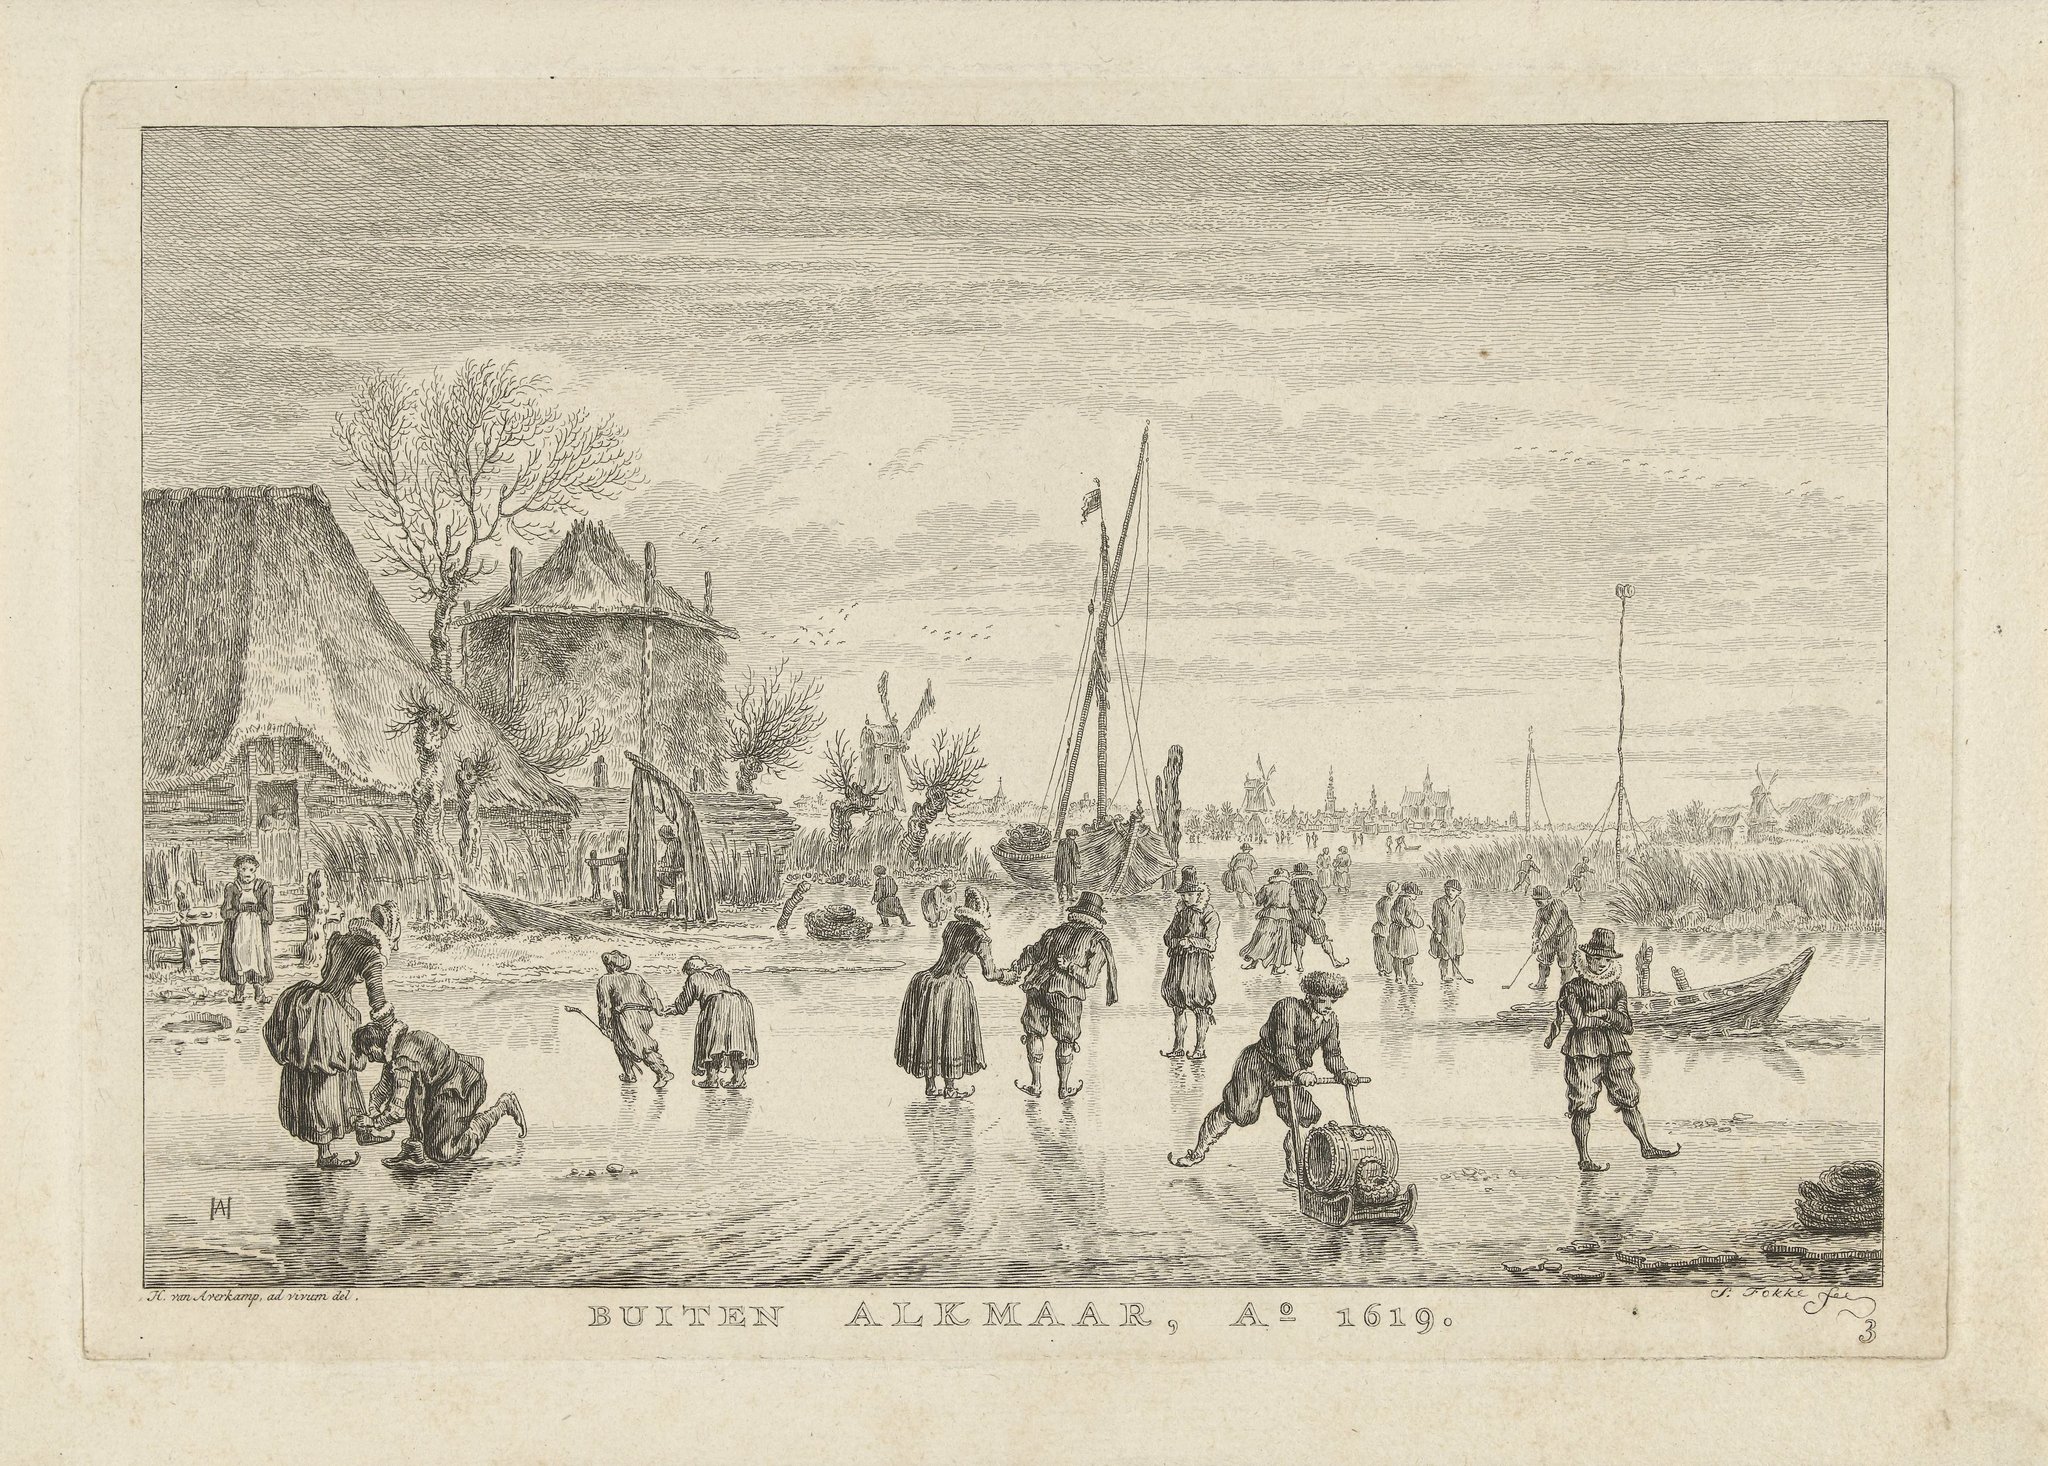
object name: print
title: Buiten Alkmaar, Ao 1619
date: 1722-1784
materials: paper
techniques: etching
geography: amsterdam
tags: winter landscape; landscape symbolizing winter (the four seasons of the year), skates (winter sports), 'kolf' on the ice, with chair on ice - cc - adult(s) ~ snow and ice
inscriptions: collector's mark: Lugt 240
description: IJsvermaak nabij Alkmaar. Op het ijs bevinden zich schaatsende figuren en kolfspelers. In de verte de stad Alkmaar.